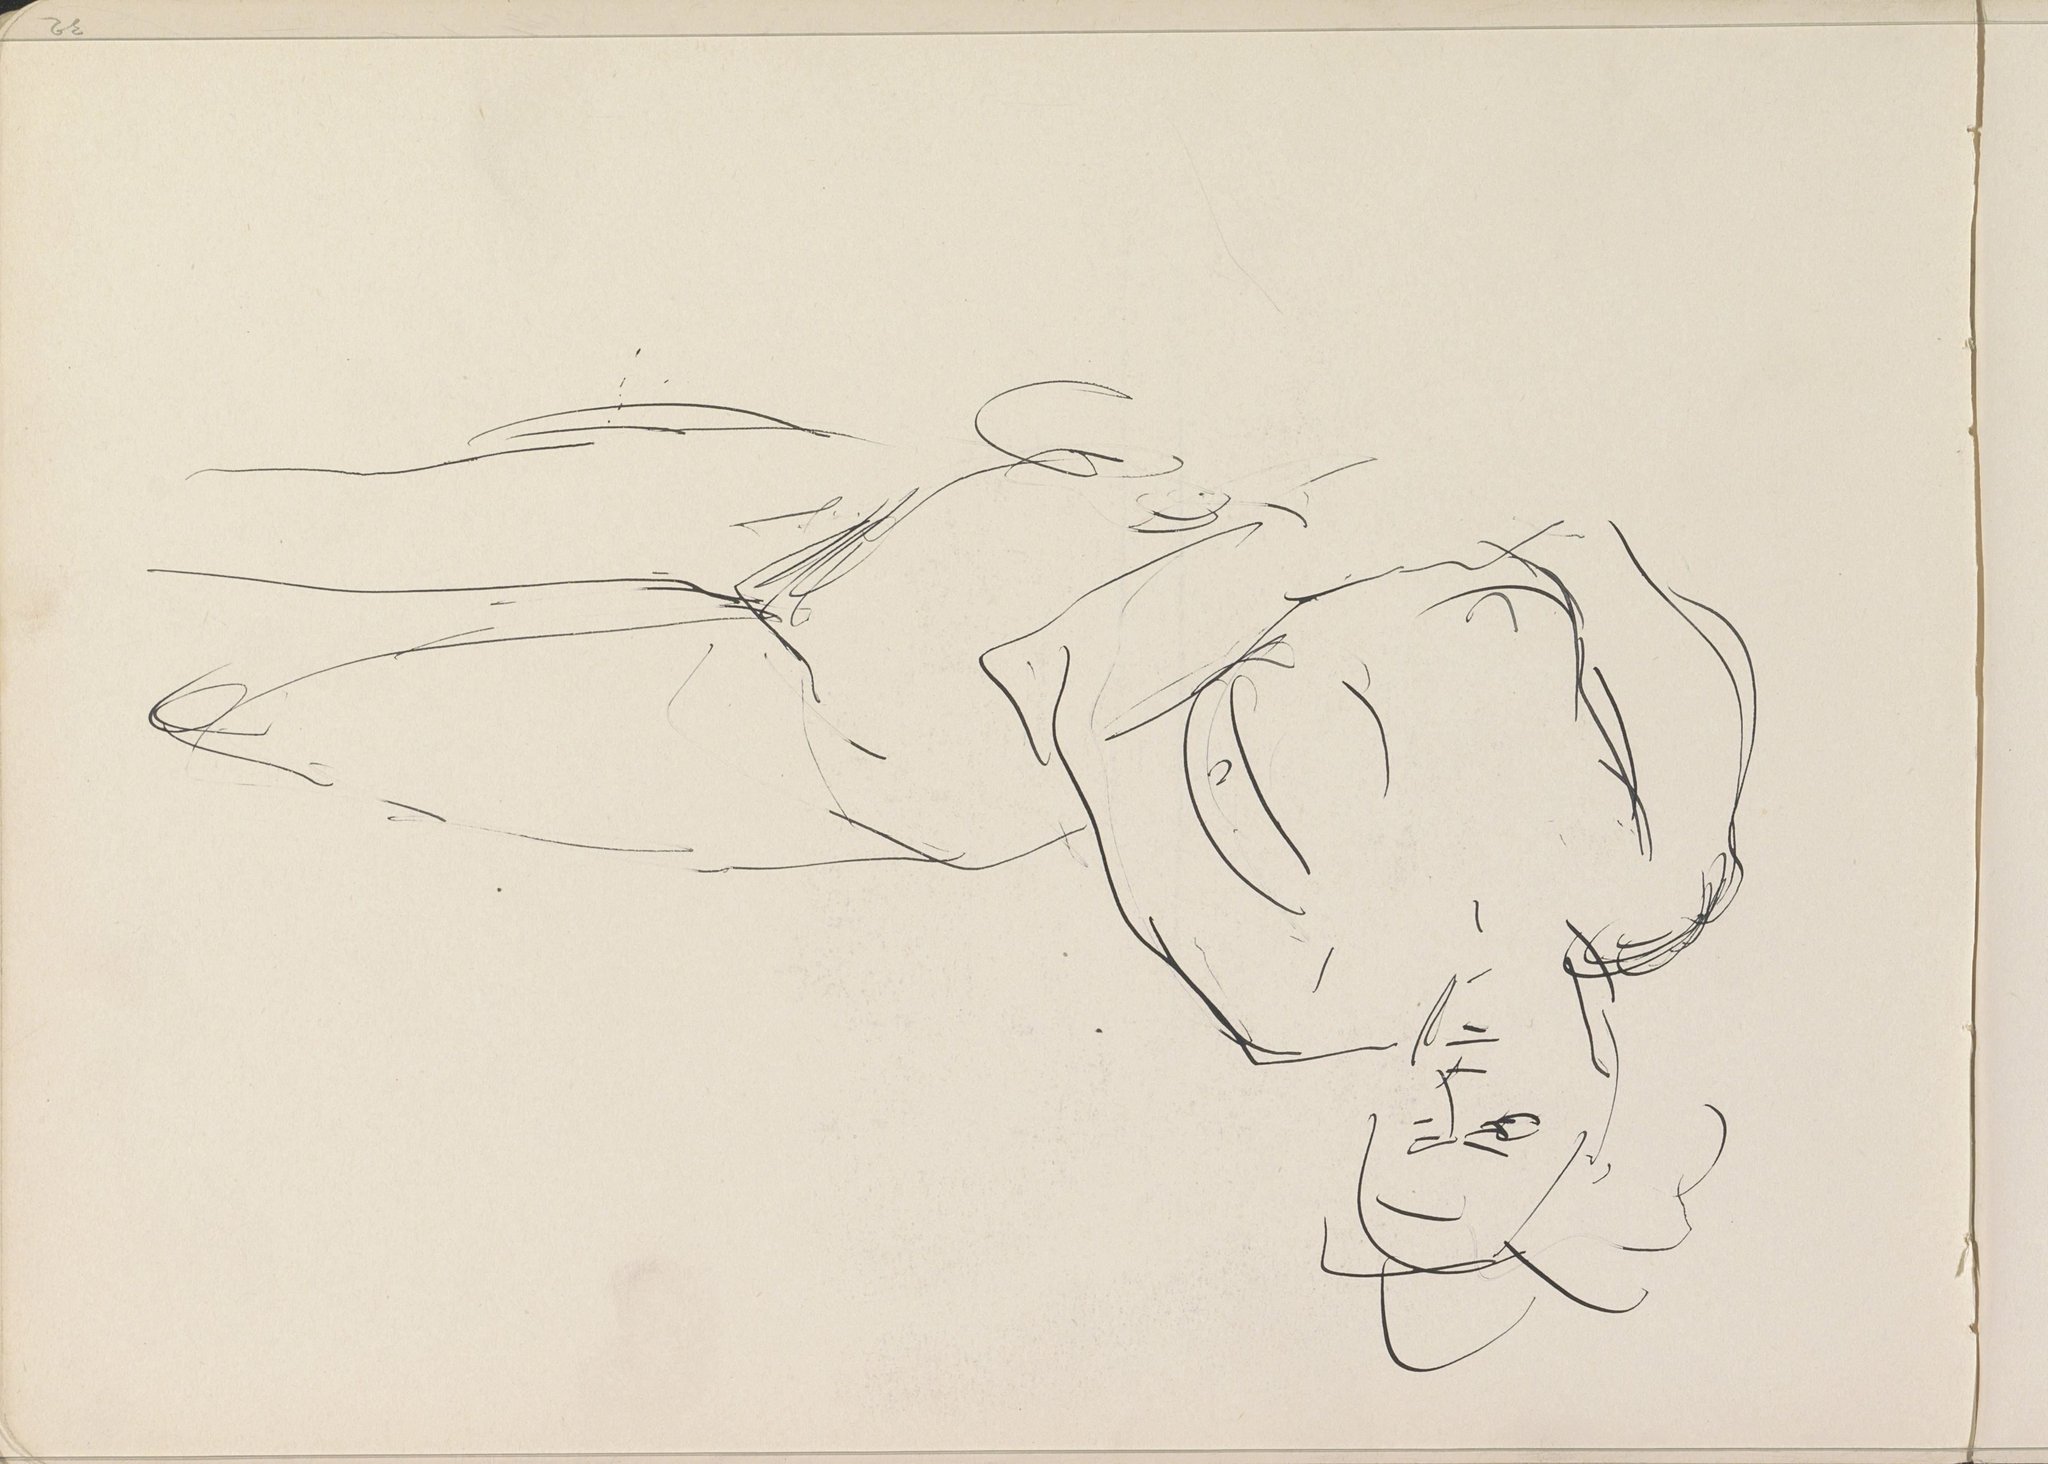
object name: sketchbook leaf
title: Reclining Female Nude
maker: isaac israels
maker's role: draughtsman, painter, print maker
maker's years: 1865-1934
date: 1875-1934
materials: ink, paper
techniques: pen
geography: the hague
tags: lying on one side, with uplifted upper part of the body and leaning on the arm - aa - female human figure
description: Ze ligt op haar zij en steunt op haar rechterarm. Blad 15 verso uit schetsboek II met 23 bladen.